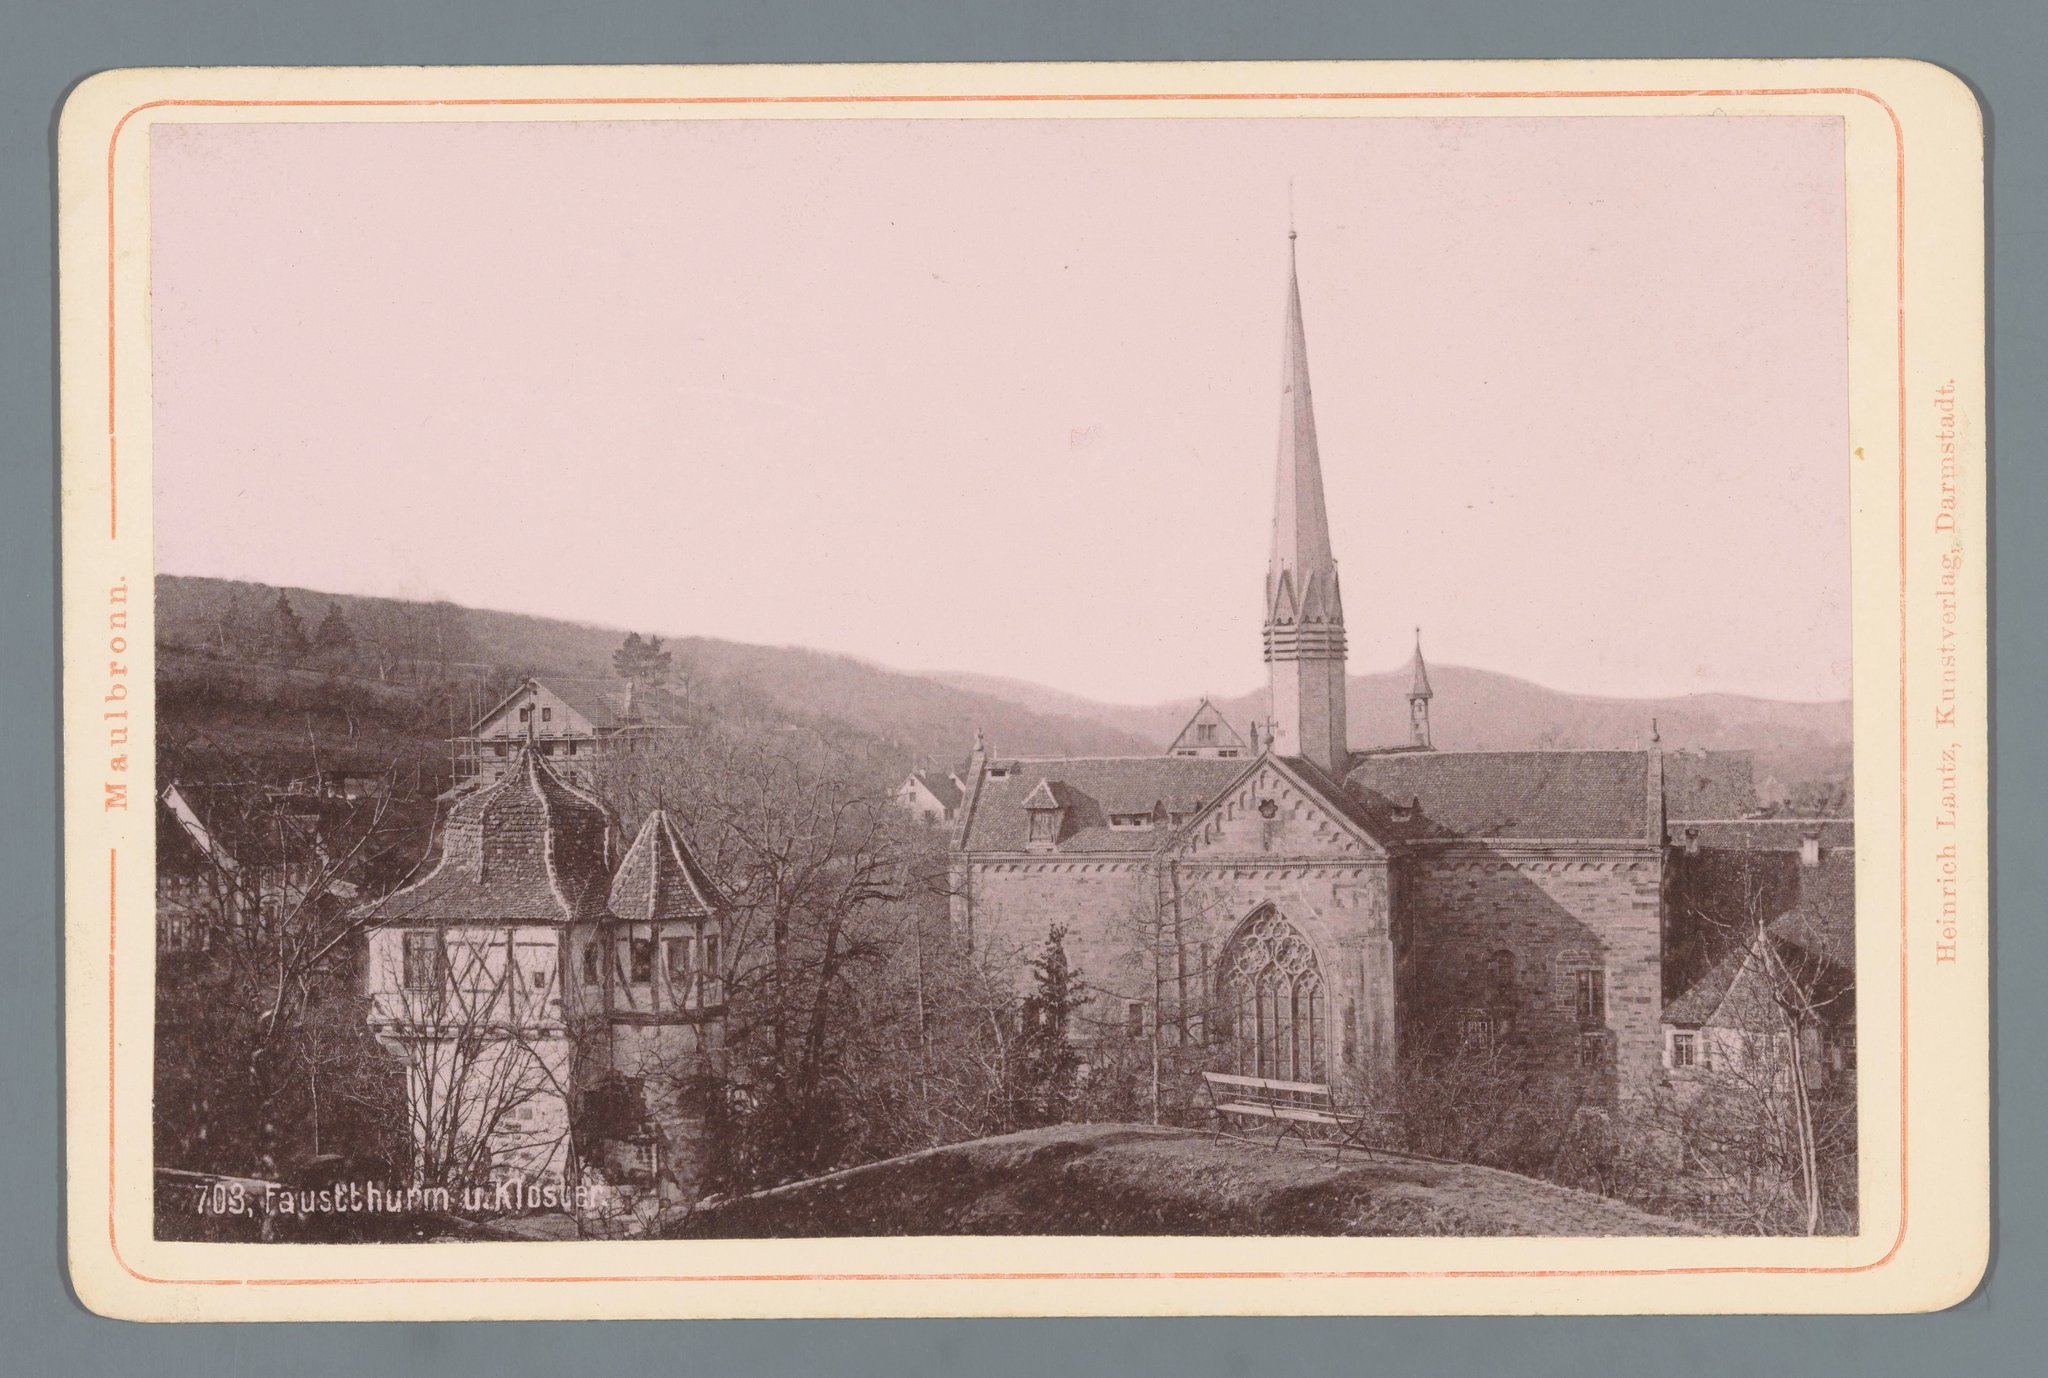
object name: photomechanical print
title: Maulbronn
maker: Anonymous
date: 1895-1900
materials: cardboard, paper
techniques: photograph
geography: maulbronn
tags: tower, clock tower ~ monumental adornment, abbey, monastery, convent ~ roman catholic church, façade (of house or building)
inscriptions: number: ‘703’, inscription: ‘17 Juli 1894.’